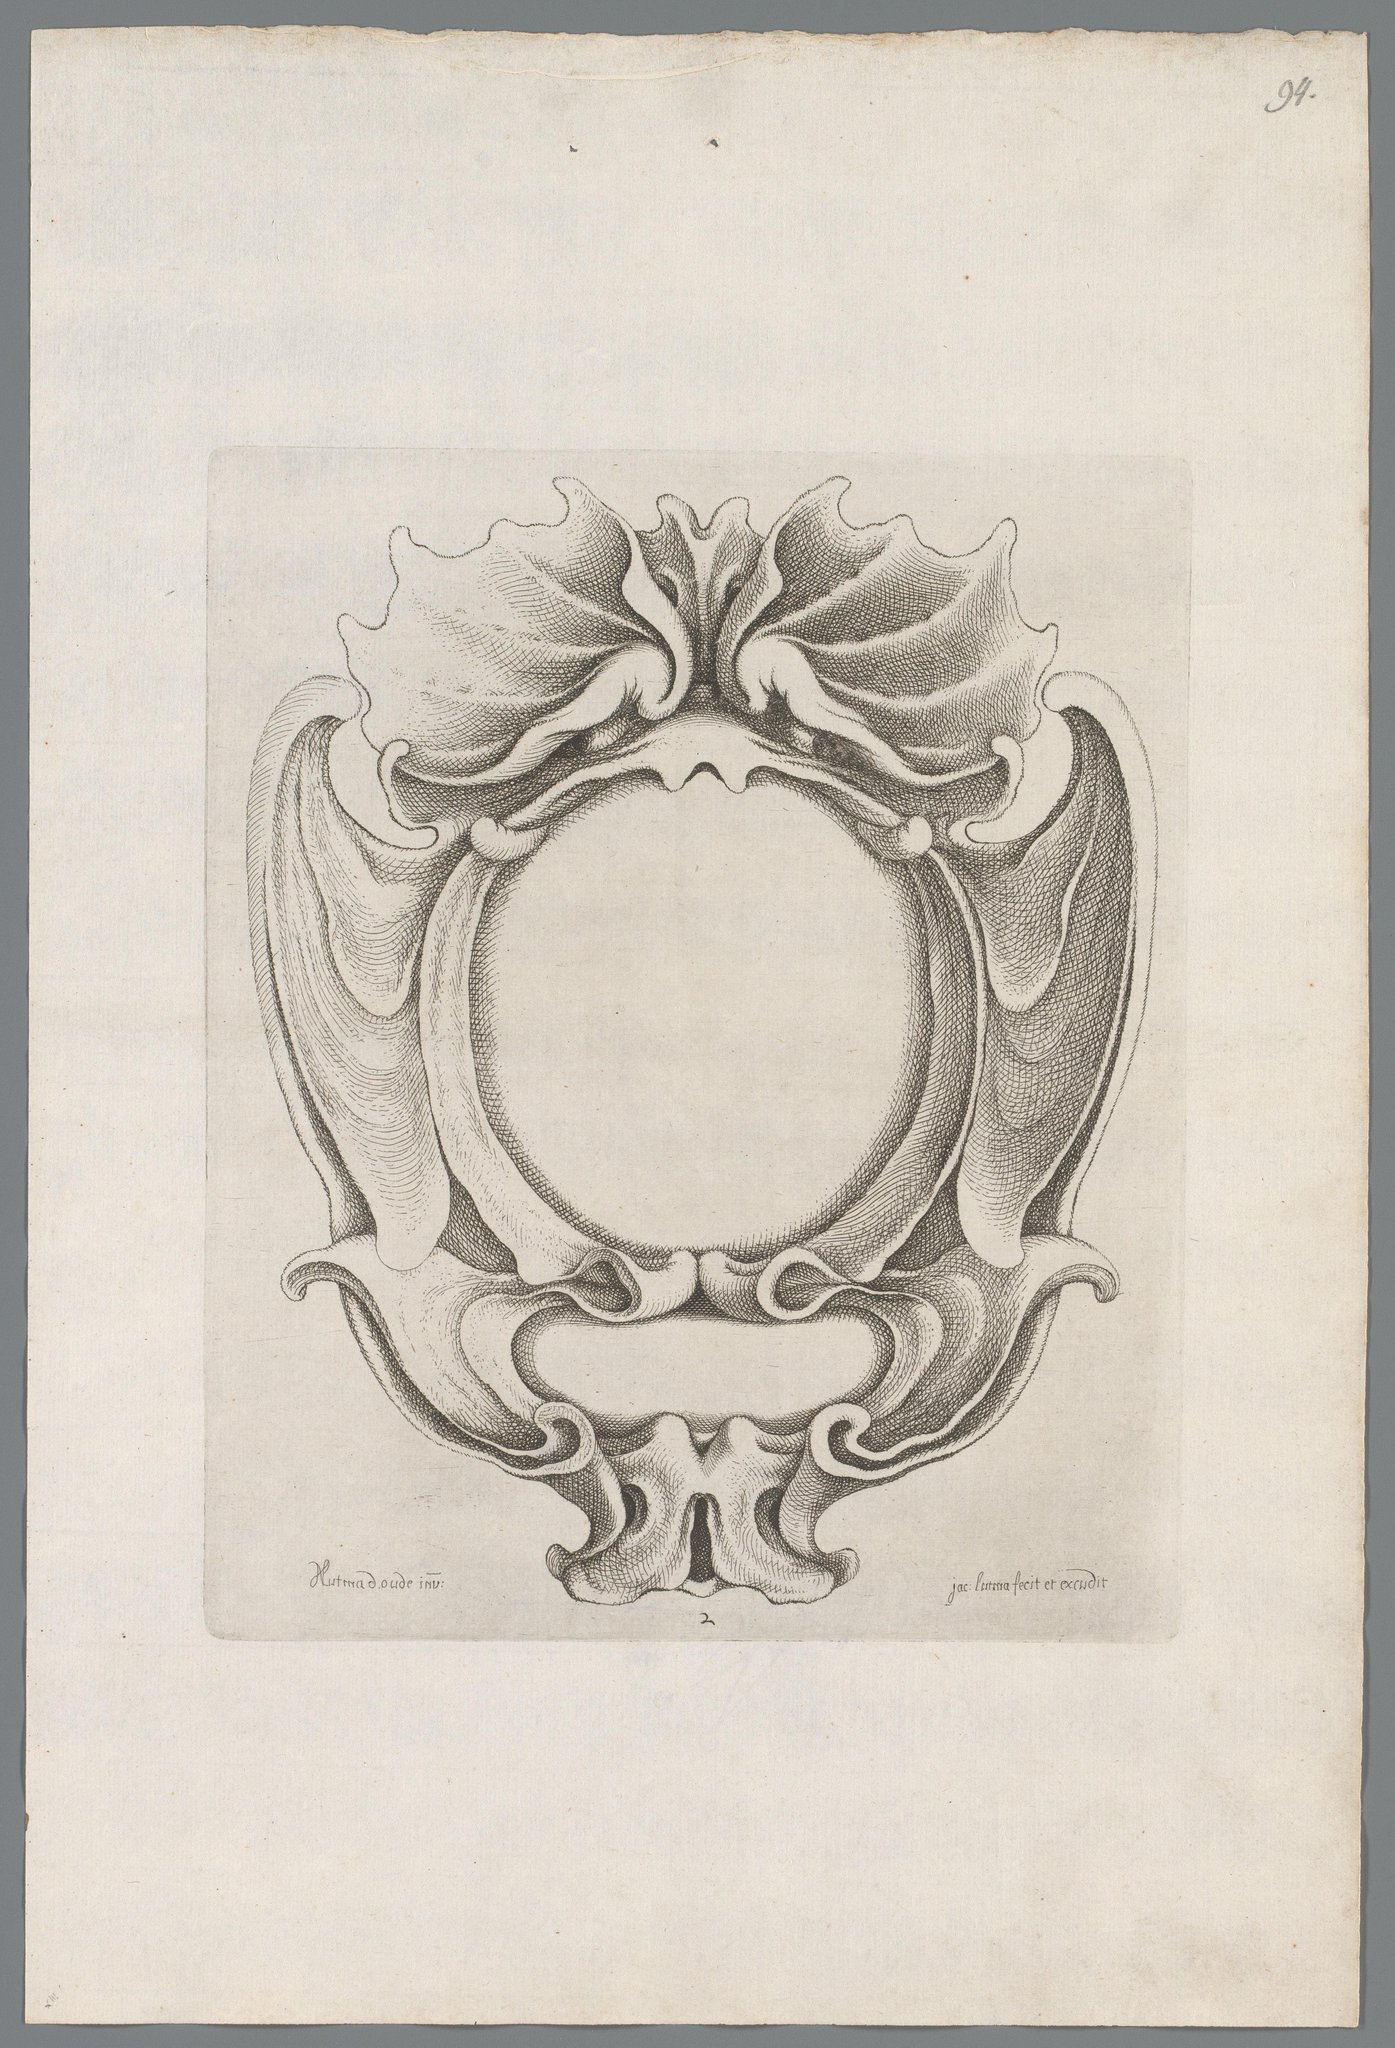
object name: ornament print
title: Ontwerpen voor cartouches en ornamenten in kwabstijl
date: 1654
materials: paper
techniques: engraving, etching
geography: amsterdam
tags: auricular ornament, lobe style ~ ornament, ornament ~ cartouche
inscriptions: collector's mark: Lugt 2760, collector's mark: Lugt 2228